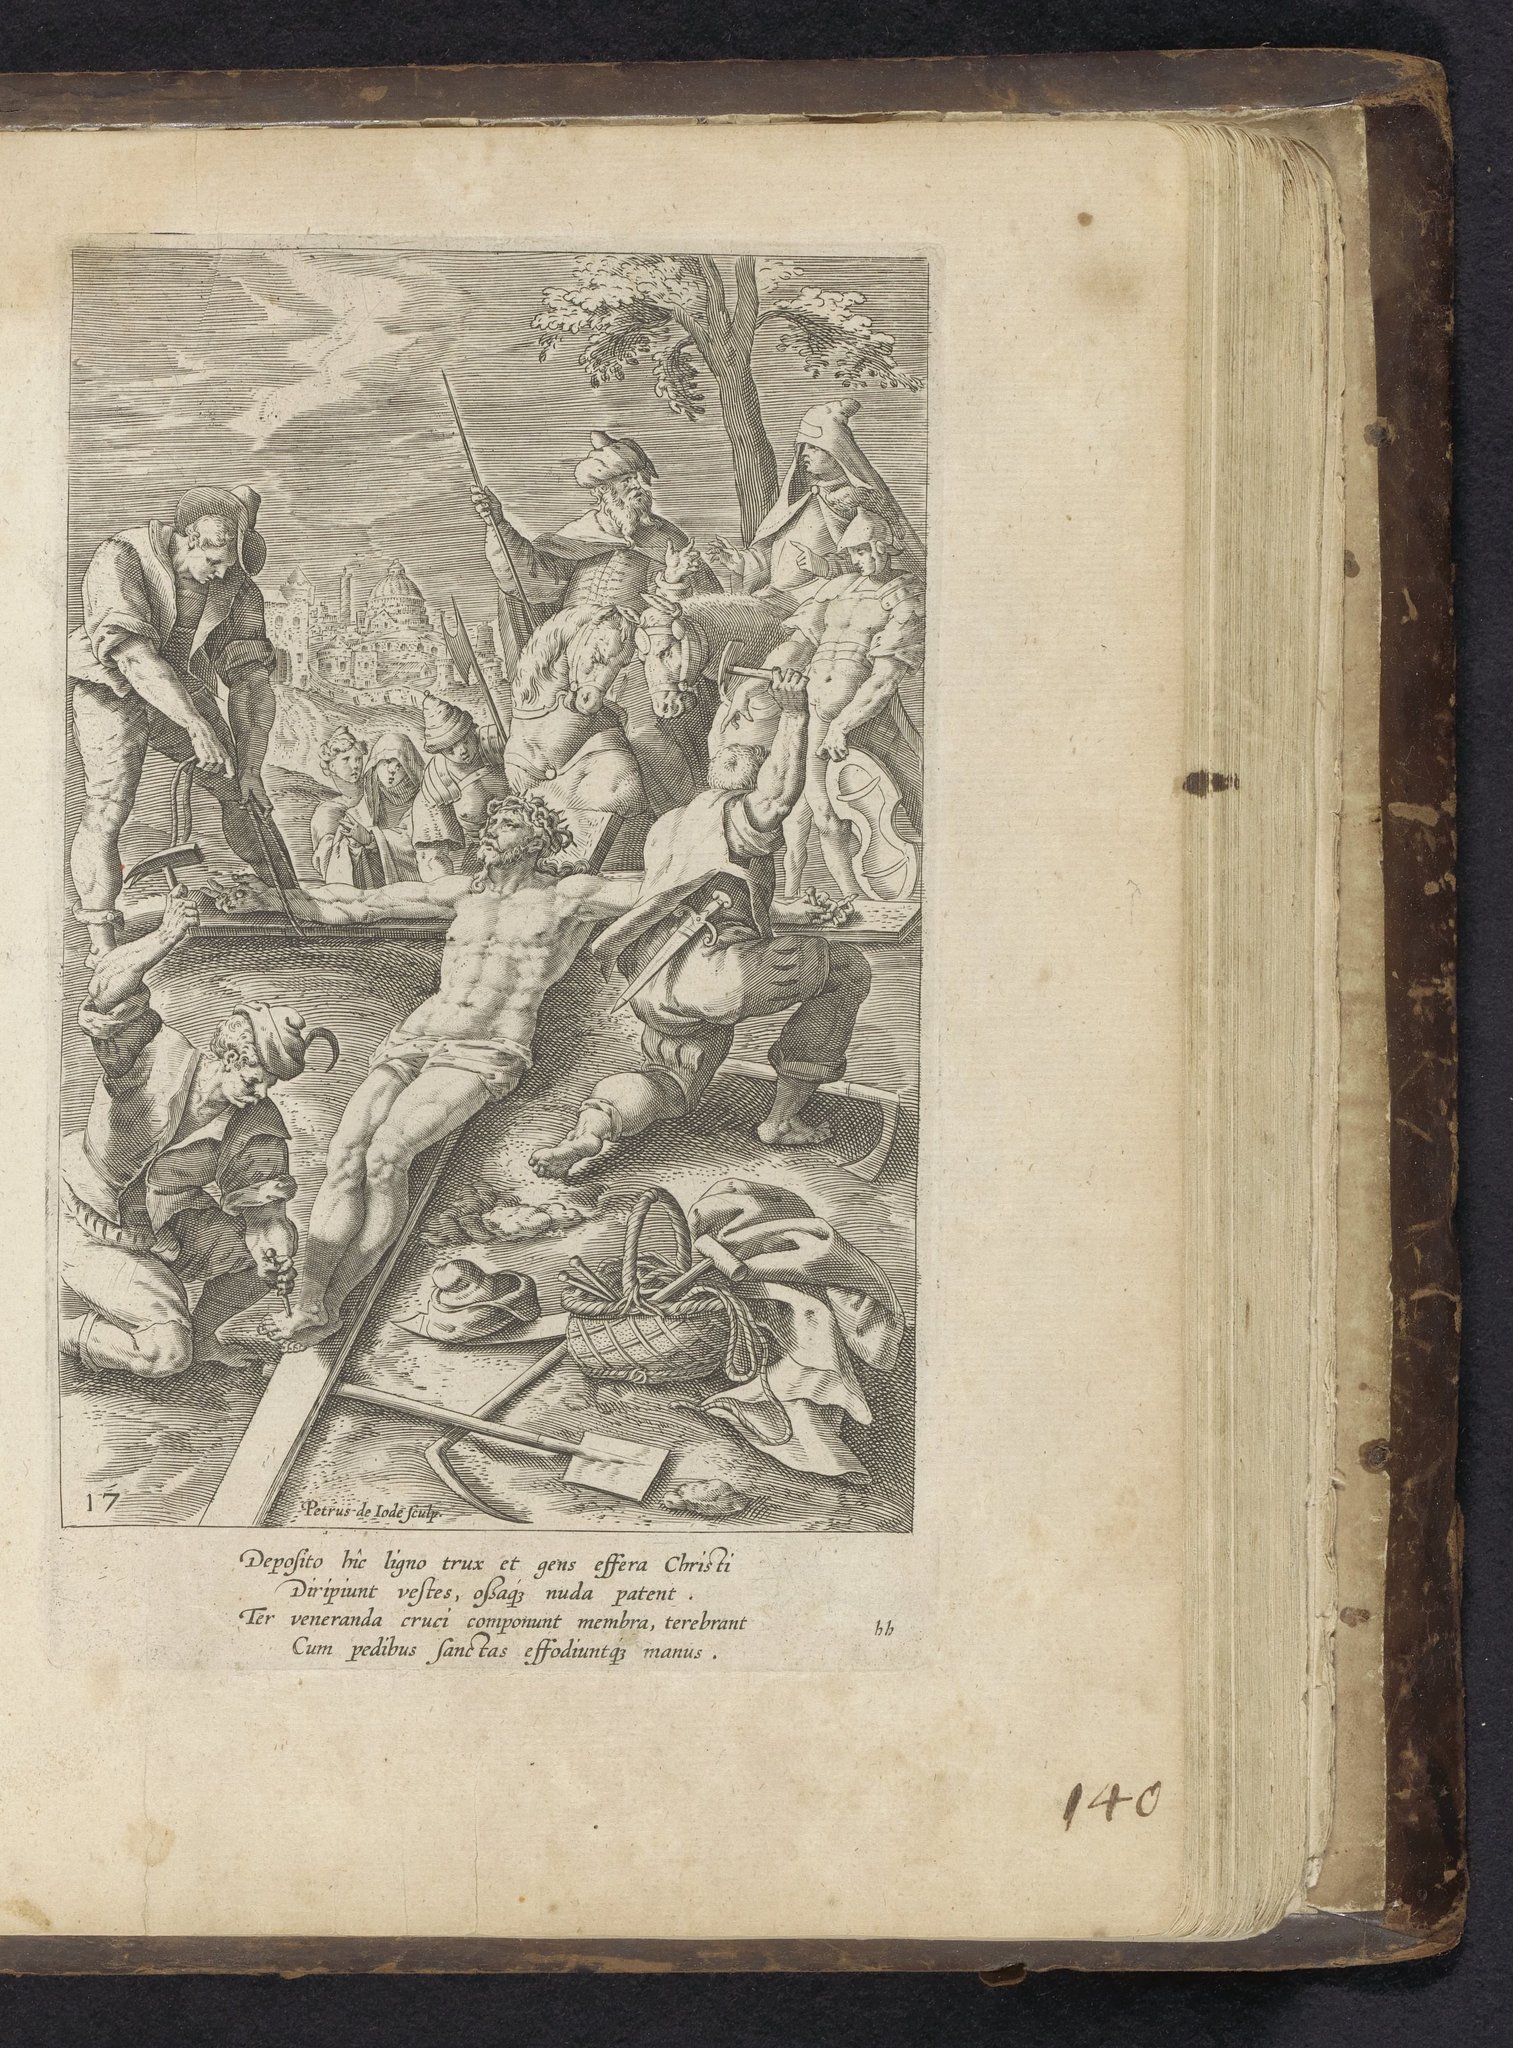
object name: album leaf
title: Den Grooten Figuer-Bibel (...)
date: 1585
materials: paper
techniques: engraving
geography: amsterdam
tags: the erection of the cross: christ is nailed to the cross which lies on the ground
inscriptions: number: ‘140’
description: Het kruis ligt op de grond. Soldaten nagelen Christus vast aan handen en voeten. Onder de voorstelling een vierregelig vers in het Latijn. Rechtsonder de letters: hh. Deze prent maakt deel uit van een album.